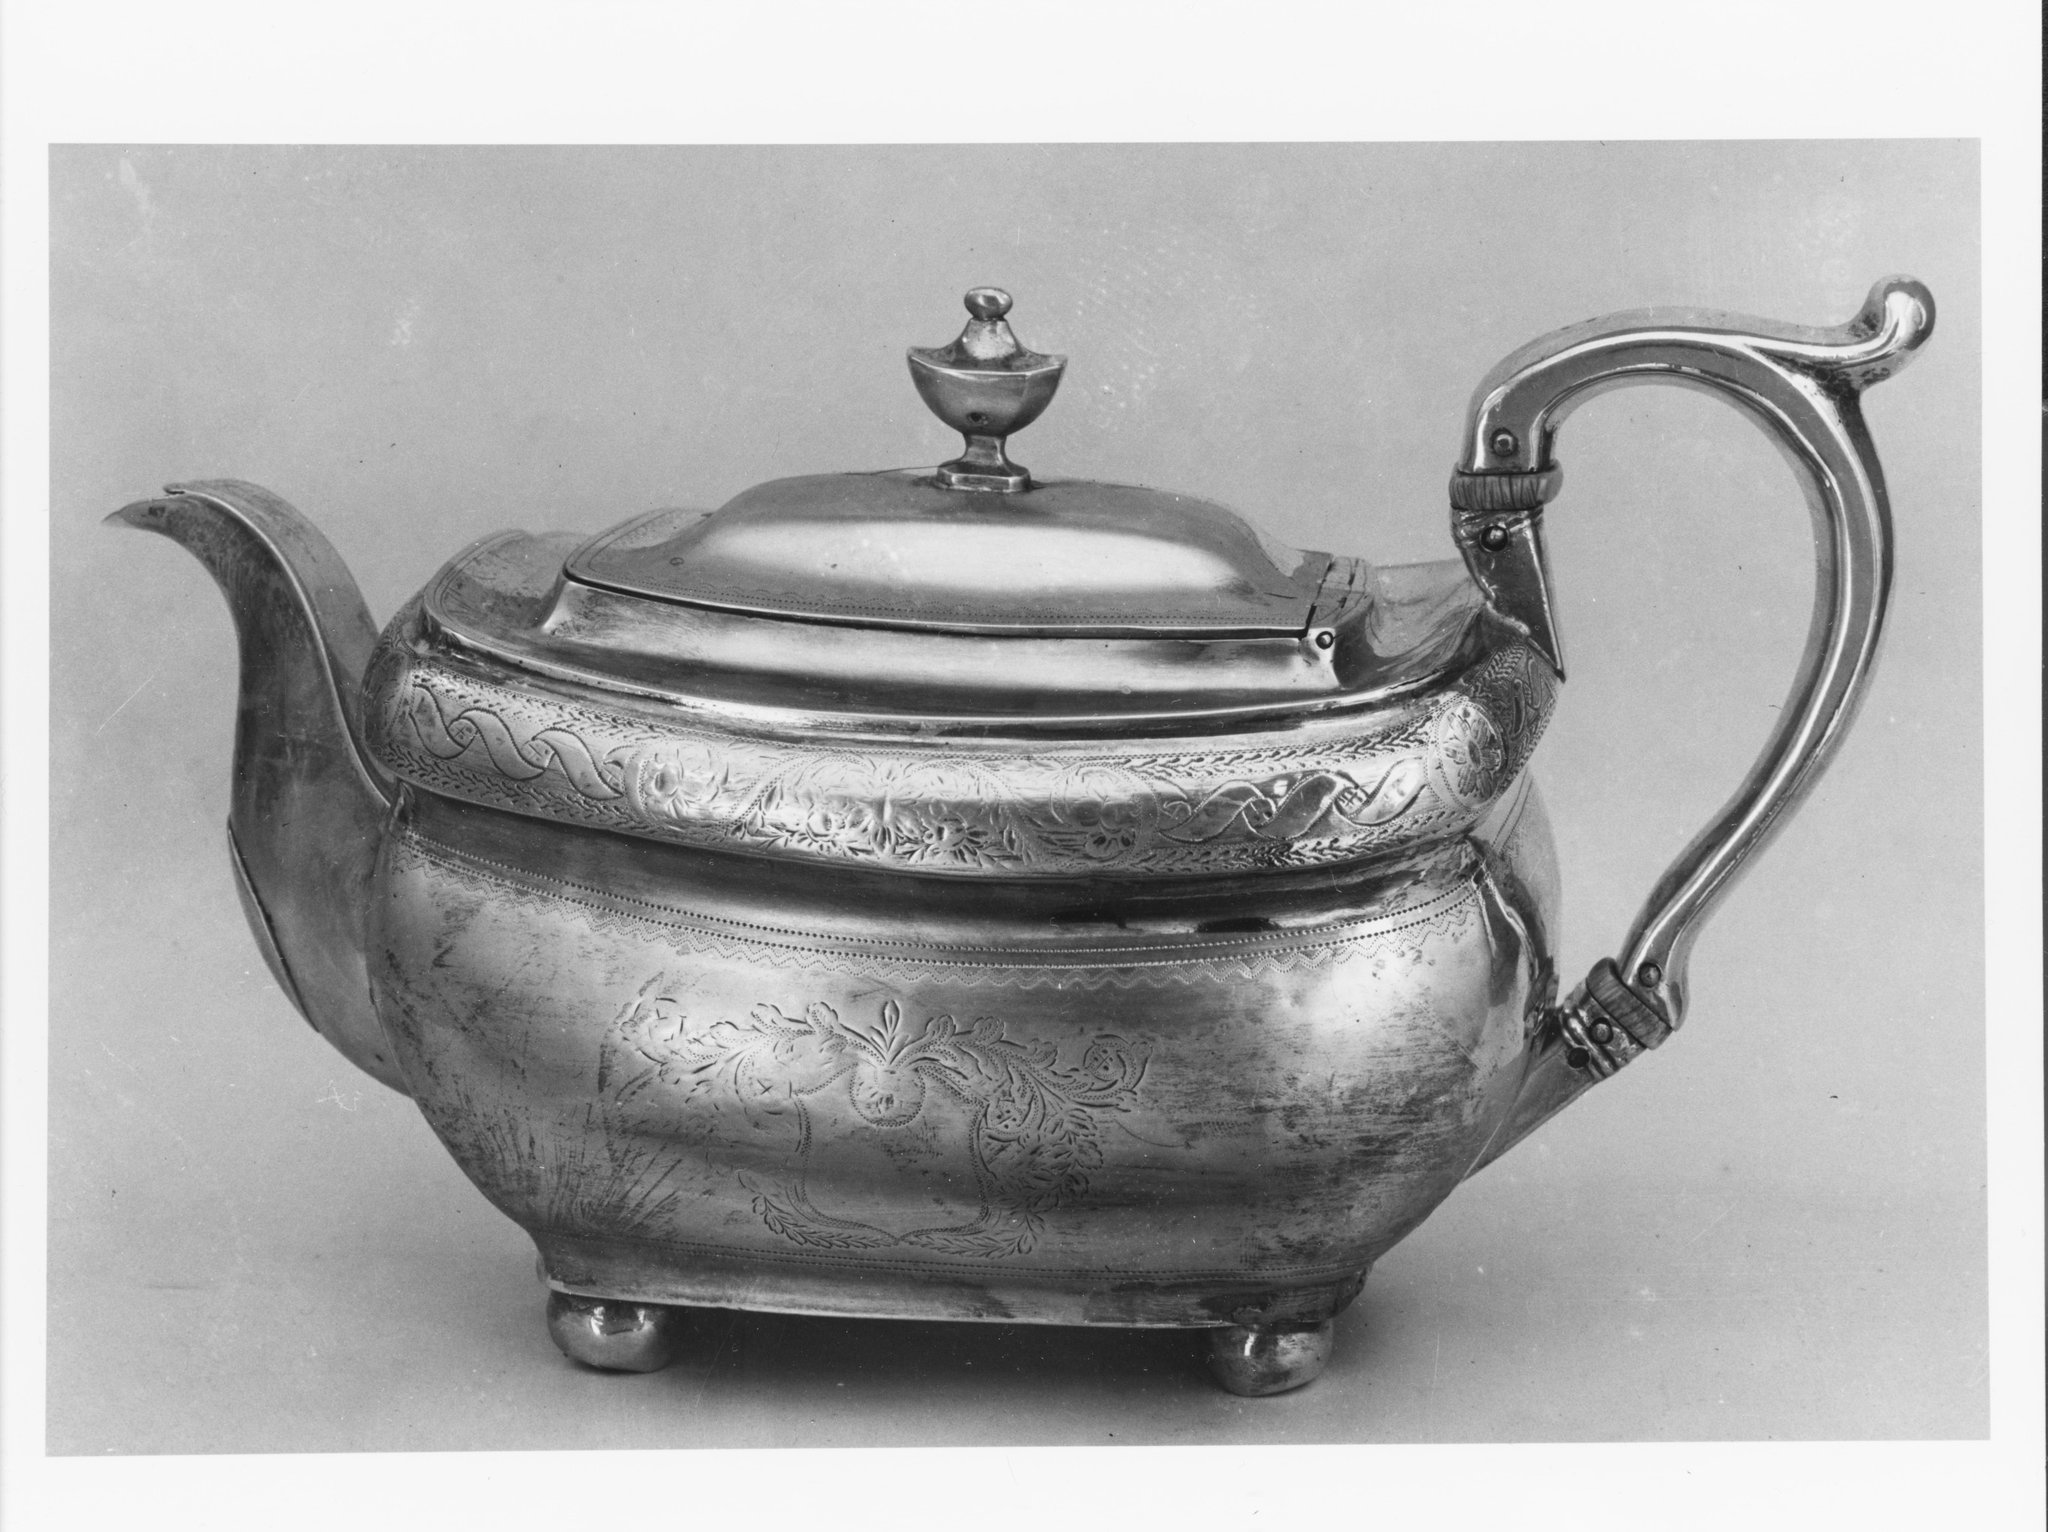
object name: teapot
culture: american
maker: hugh wishart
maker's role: maker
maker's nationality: american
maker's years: 1793-1824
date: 1800-1830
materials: silver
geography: united states